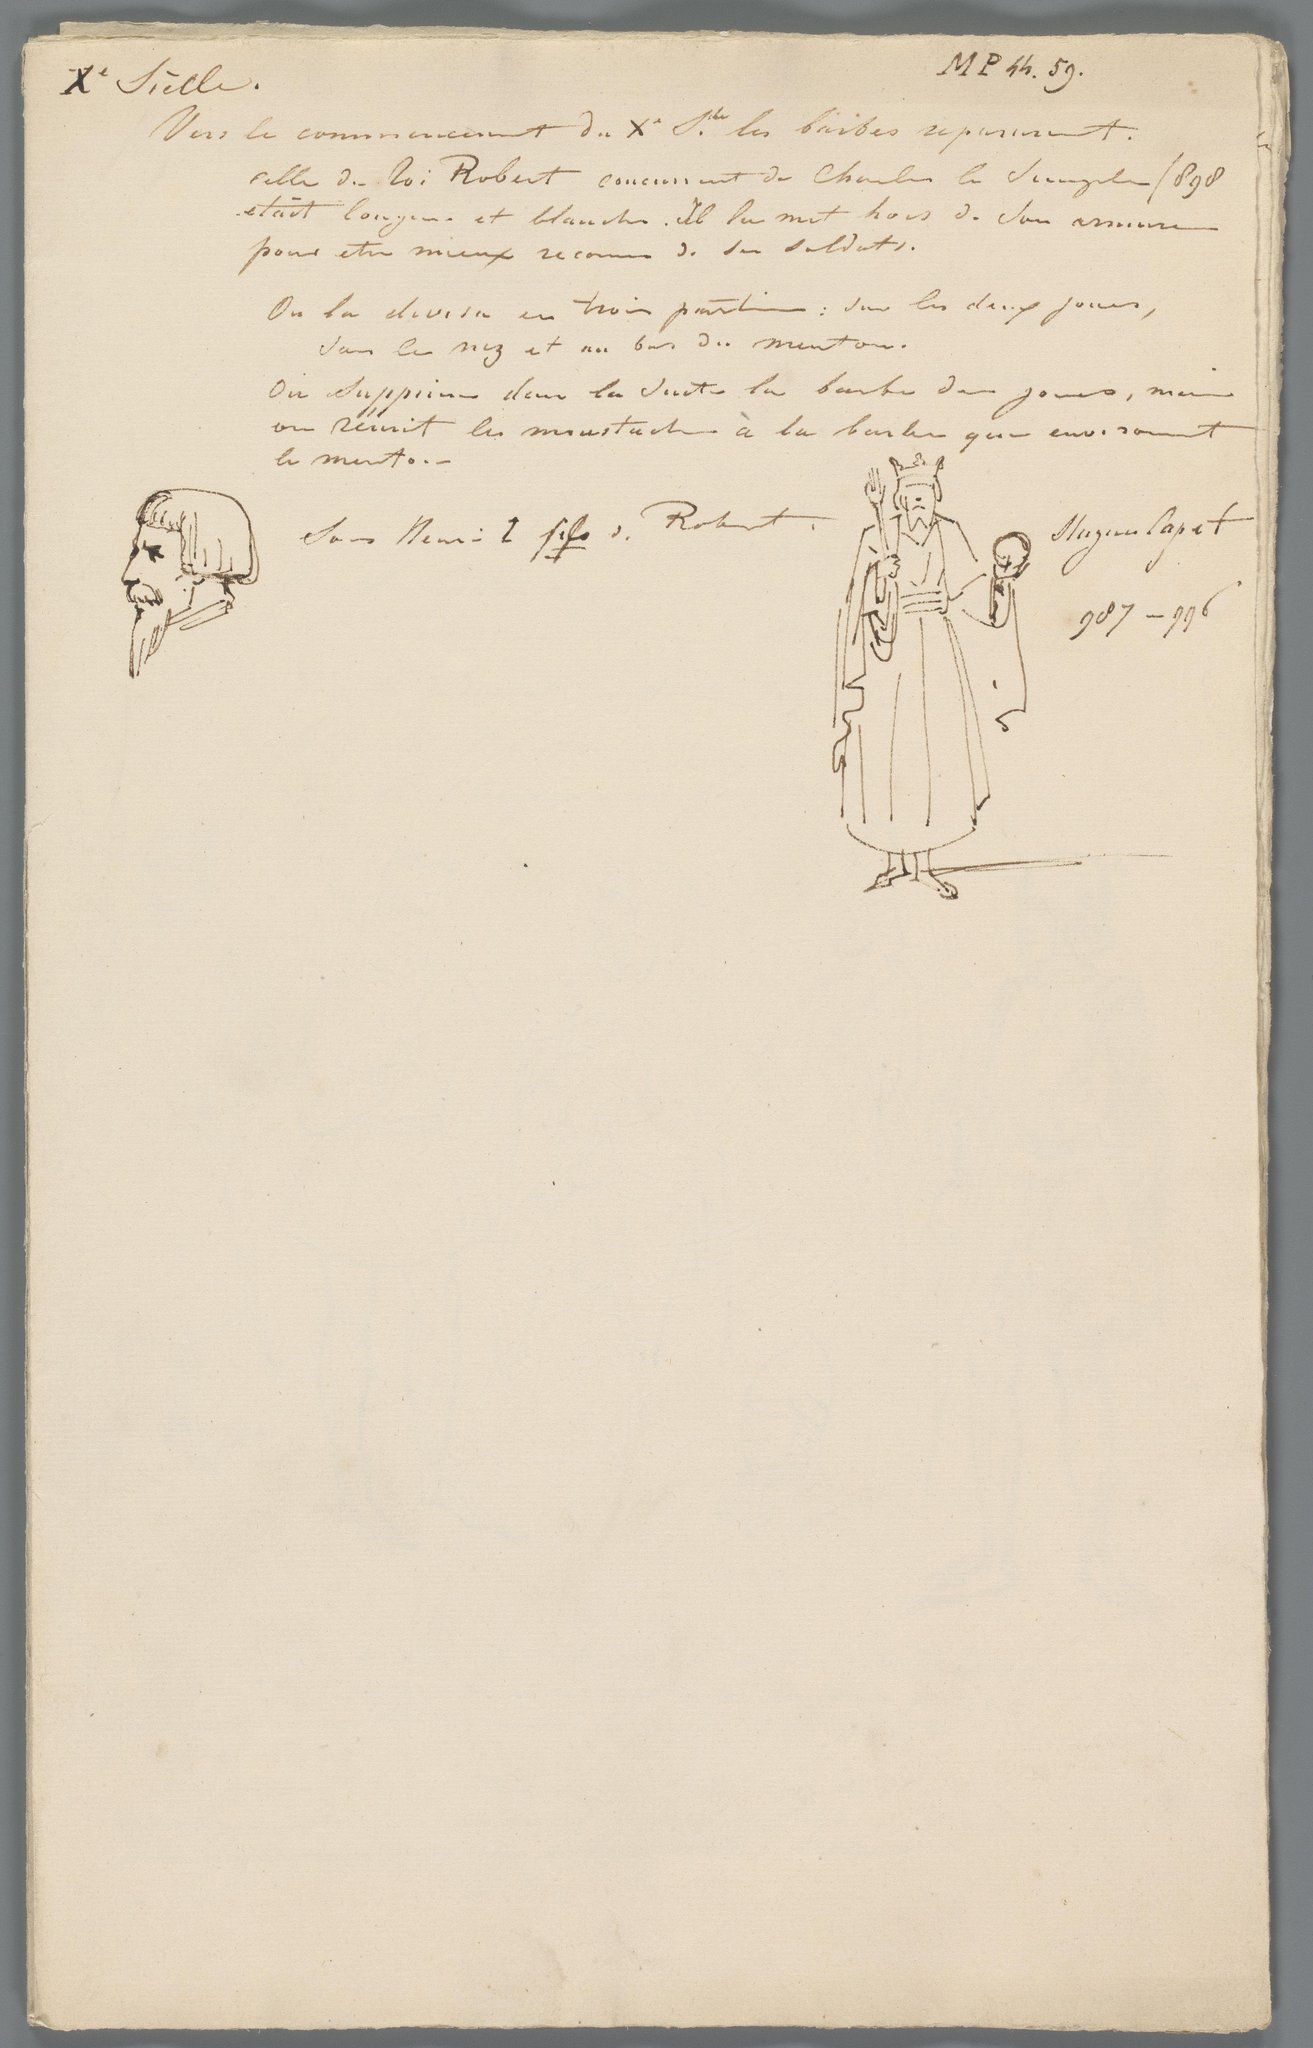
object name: drawing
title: Hugo Capet en Hendrik I, koningen van Frankrijk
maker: jacobus everhardus josephus van den berg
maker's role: draughtsman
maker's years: 1802-1861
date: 1812-1861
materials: ink, paper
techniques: pen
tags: king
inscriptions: inscription: ‘MP hh. 59’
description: Tekst mogelijk overgeschreven uit een publicatie.